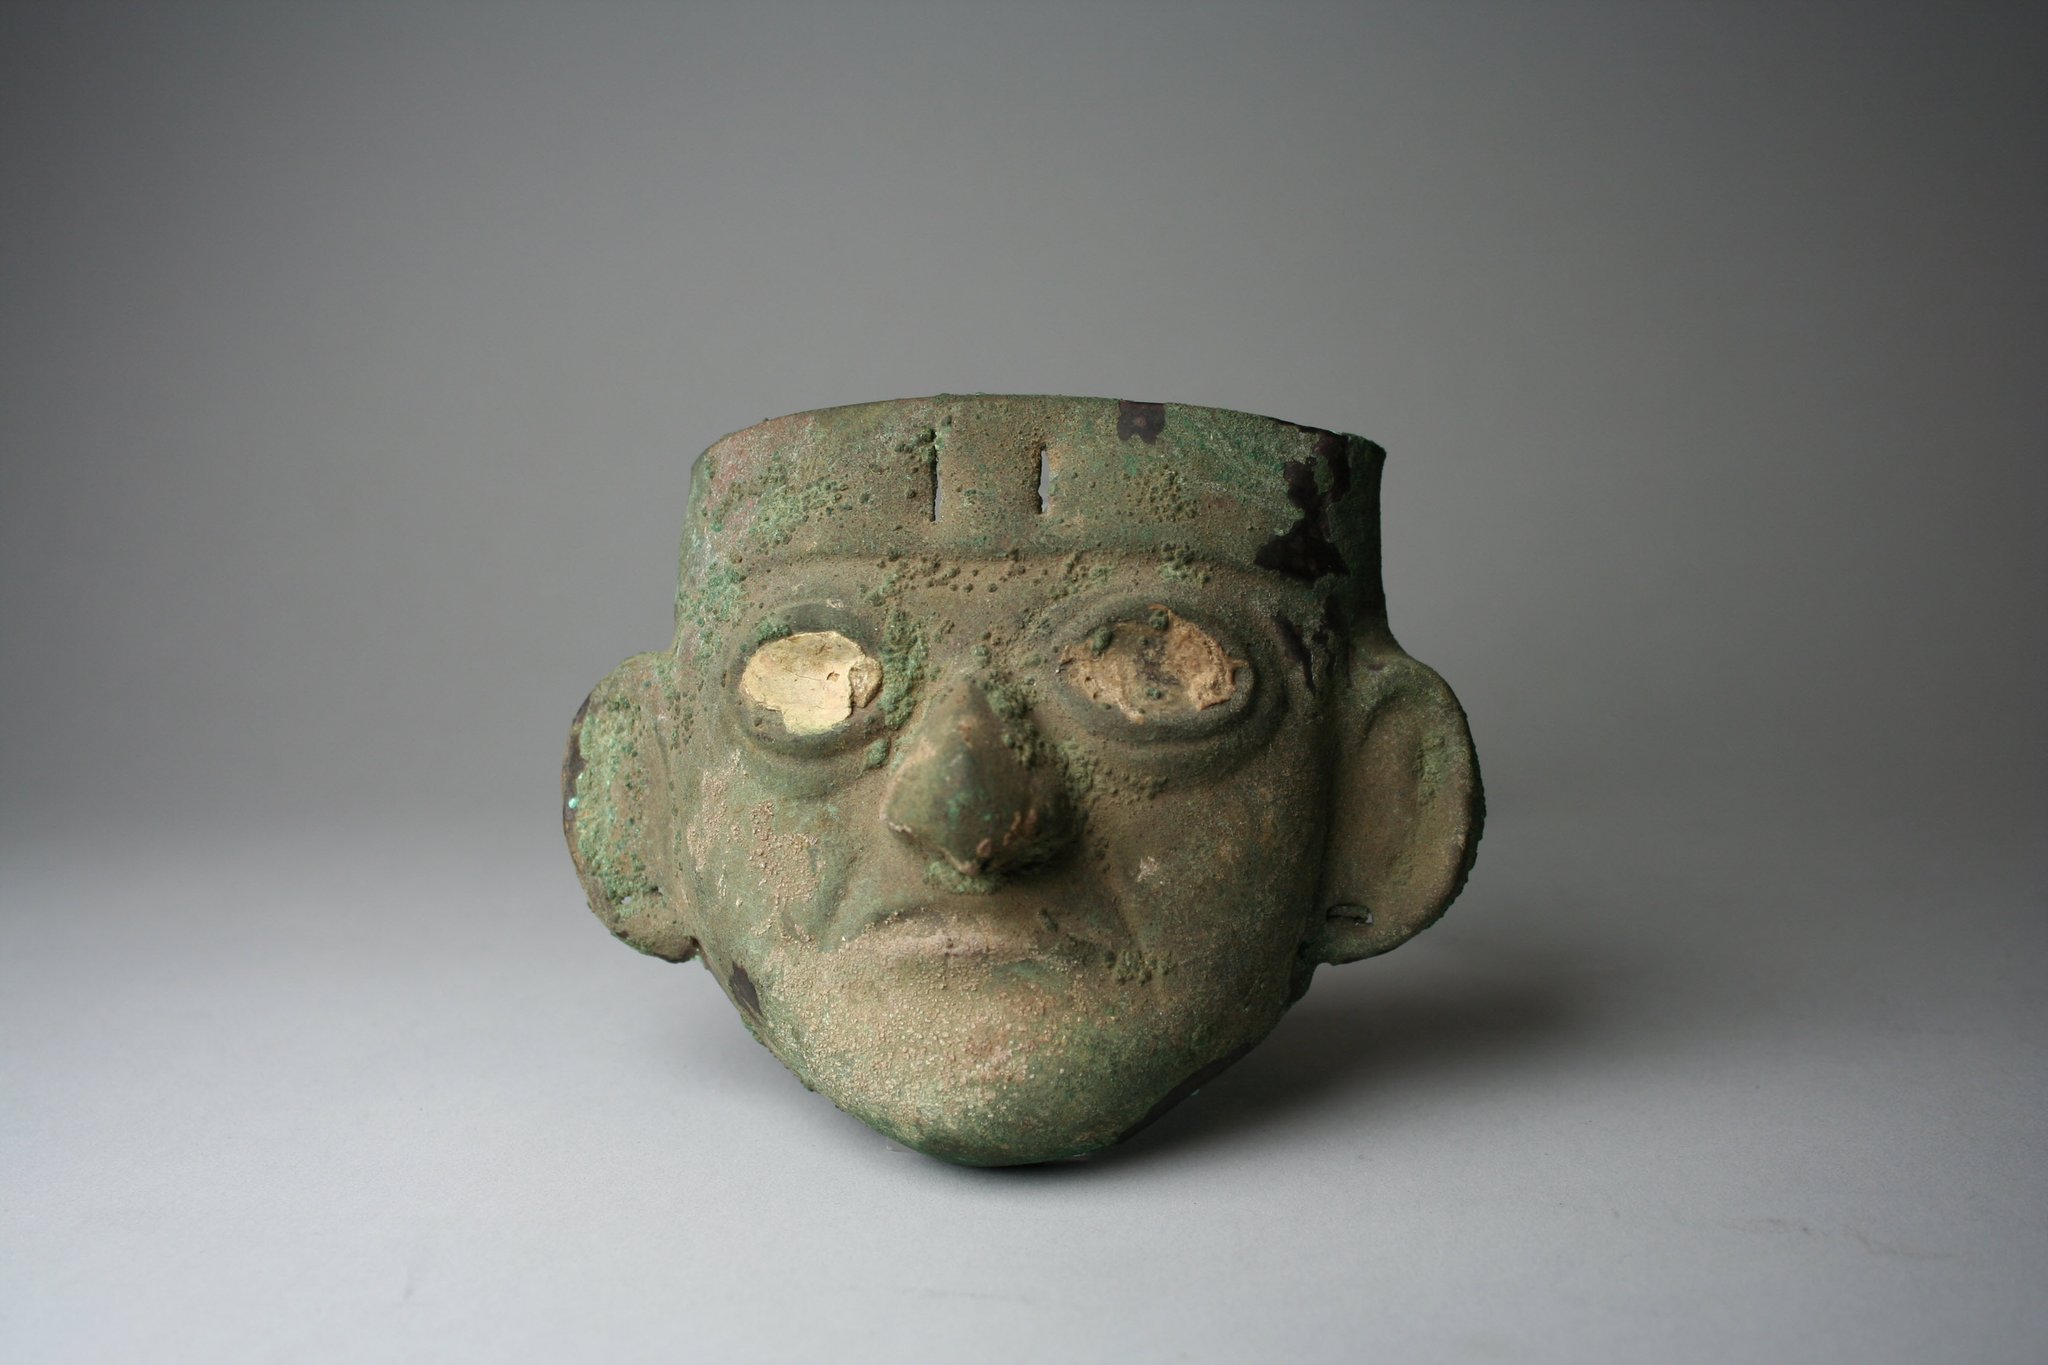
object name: ornament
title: Face Mask Ornament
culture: moche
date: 501-700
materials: metal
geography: peru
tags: masks,faces